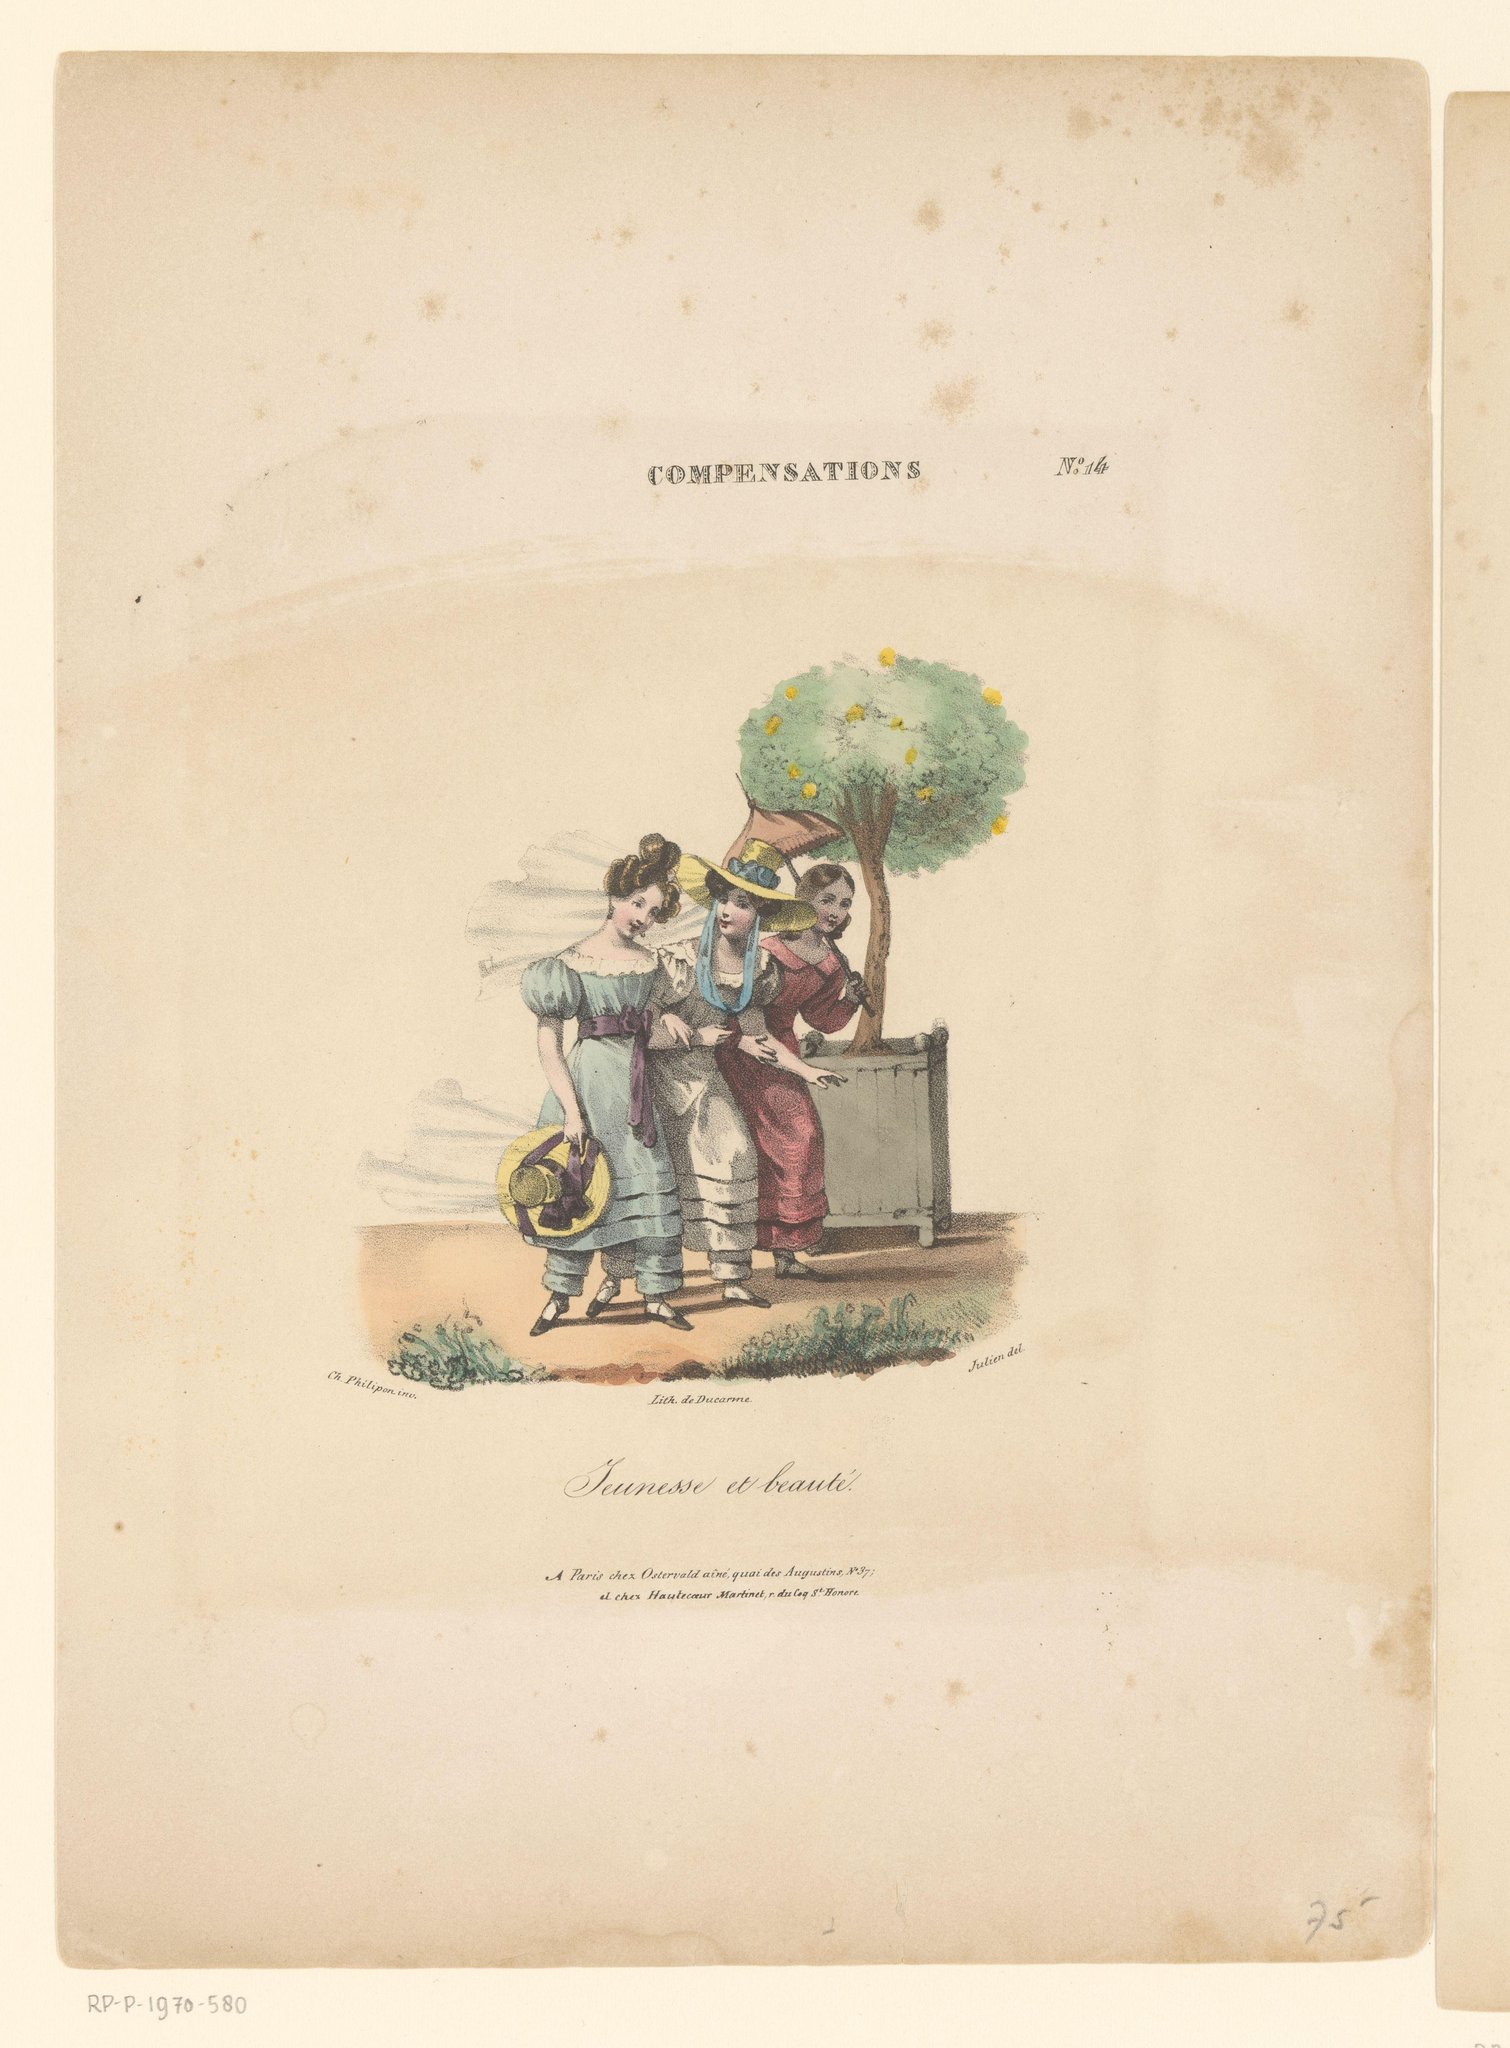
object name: print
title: Compenseren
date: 1827-1829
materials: paper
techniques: hand coloring, lithograph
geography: paris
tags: adolescent, young woman, maiden, head-gear: hat, parasol, sunshade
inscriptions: collector's mark: Lugt 2228, inscription: ‘Paul Prouté, 2 Aug. 1965 N.F. 050’